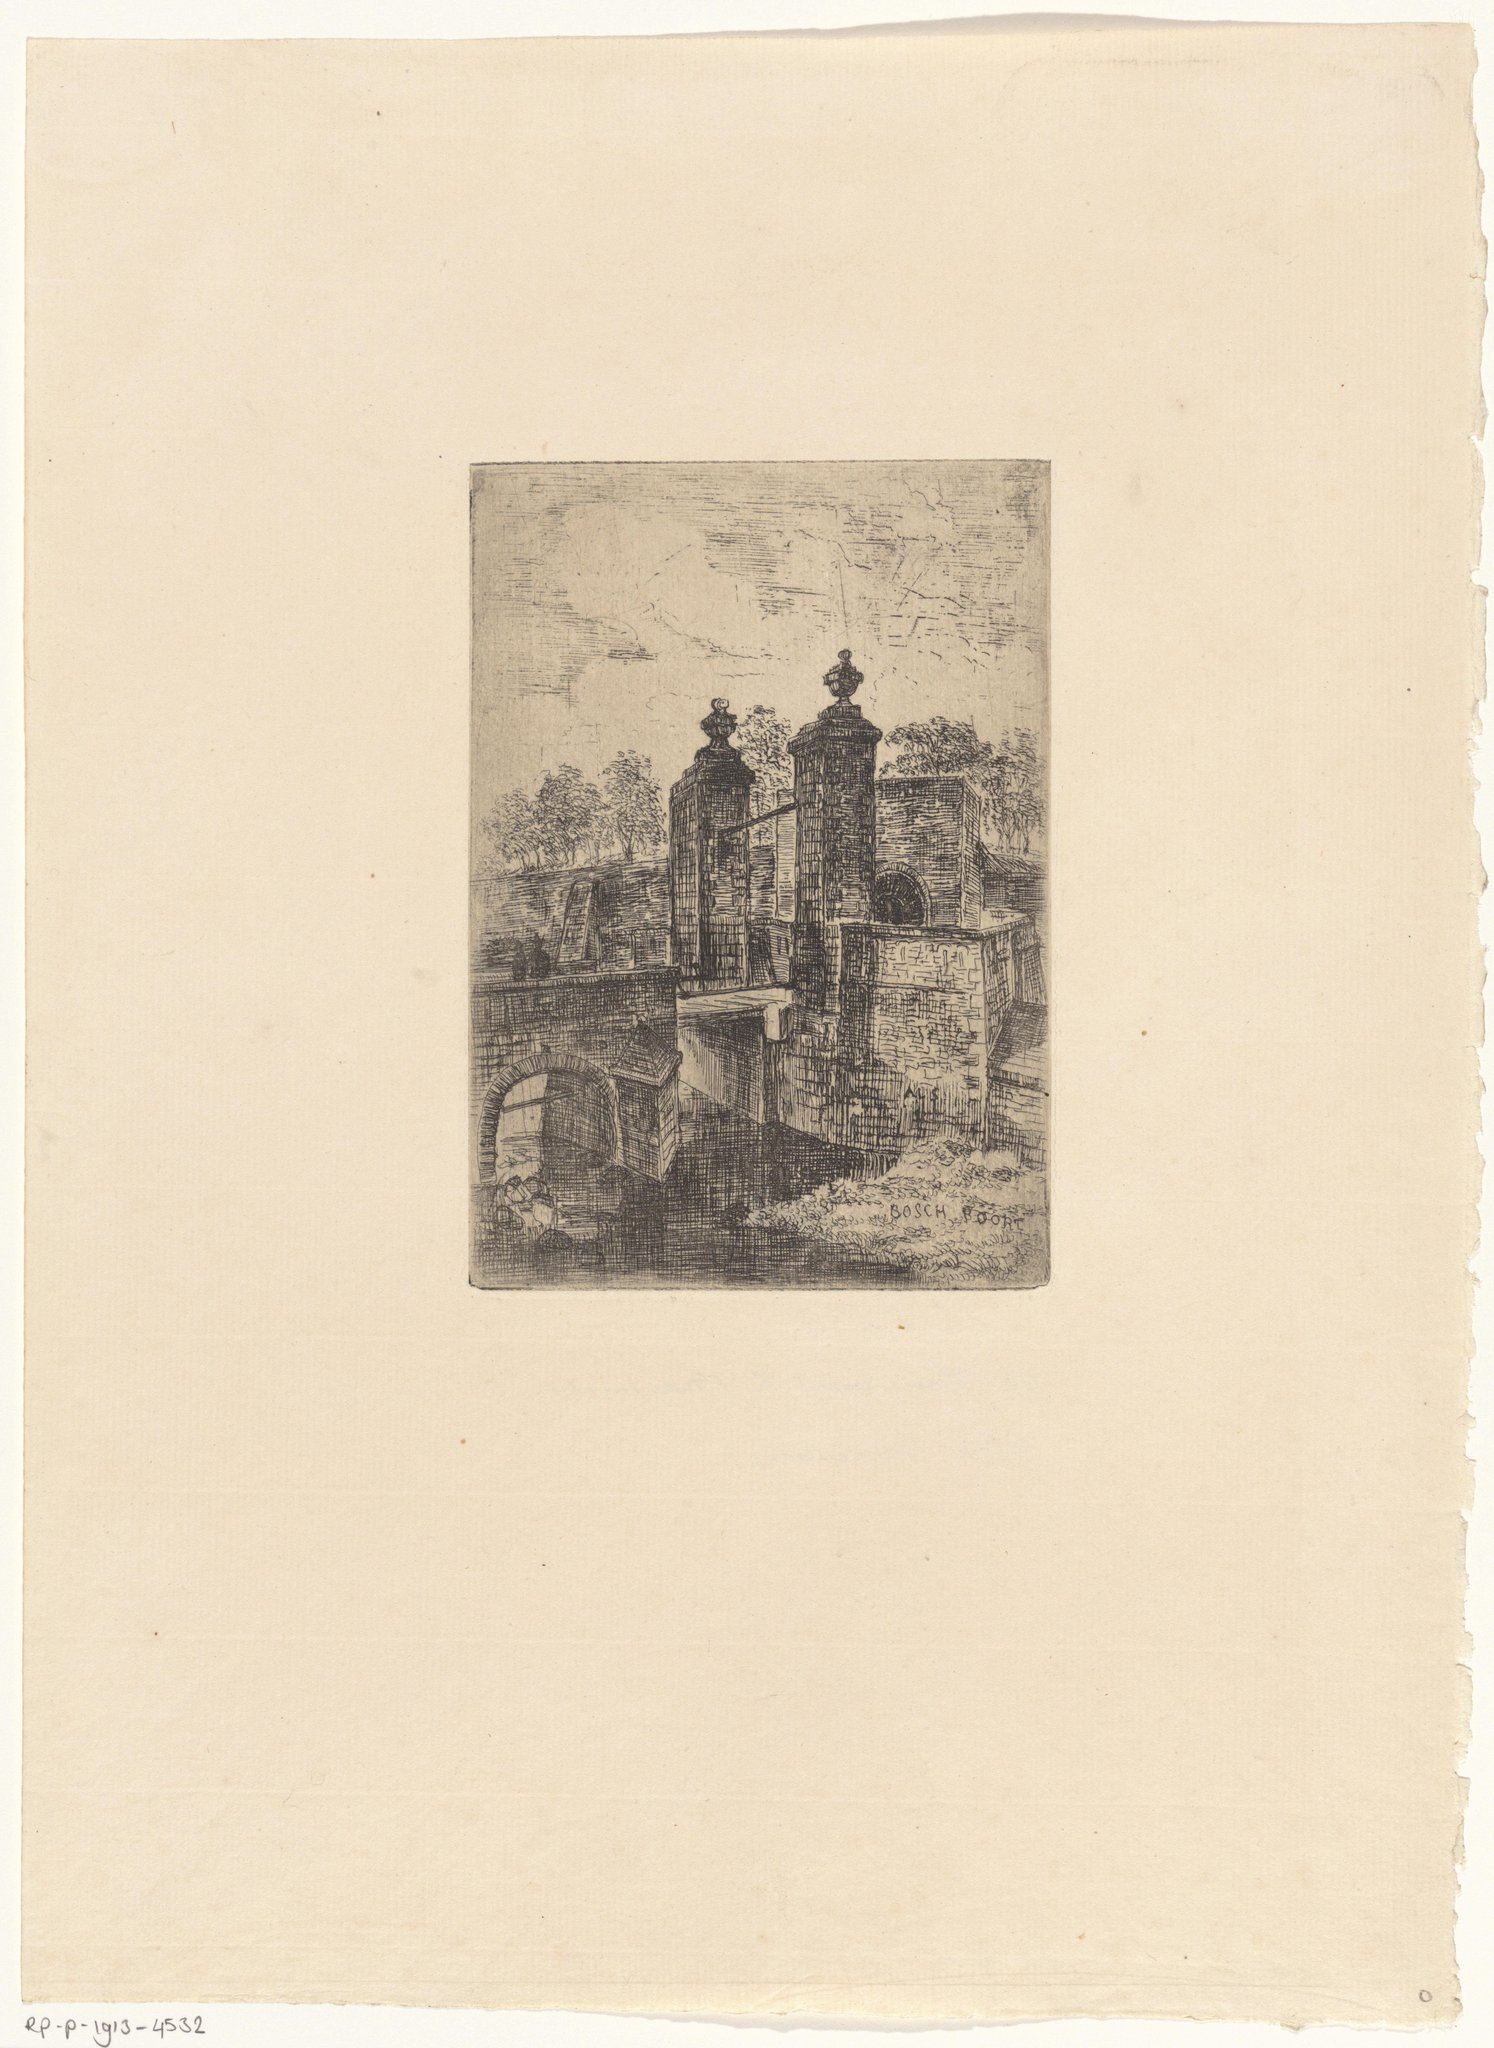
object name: print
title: Bosch Poort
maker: alexander schaepkens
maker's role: draughtsman, print maker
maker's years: 1815-1899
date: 1830-1899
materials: paper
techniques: etching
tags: city-gate, maastricht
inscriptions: collector's mark: Lugt 2228